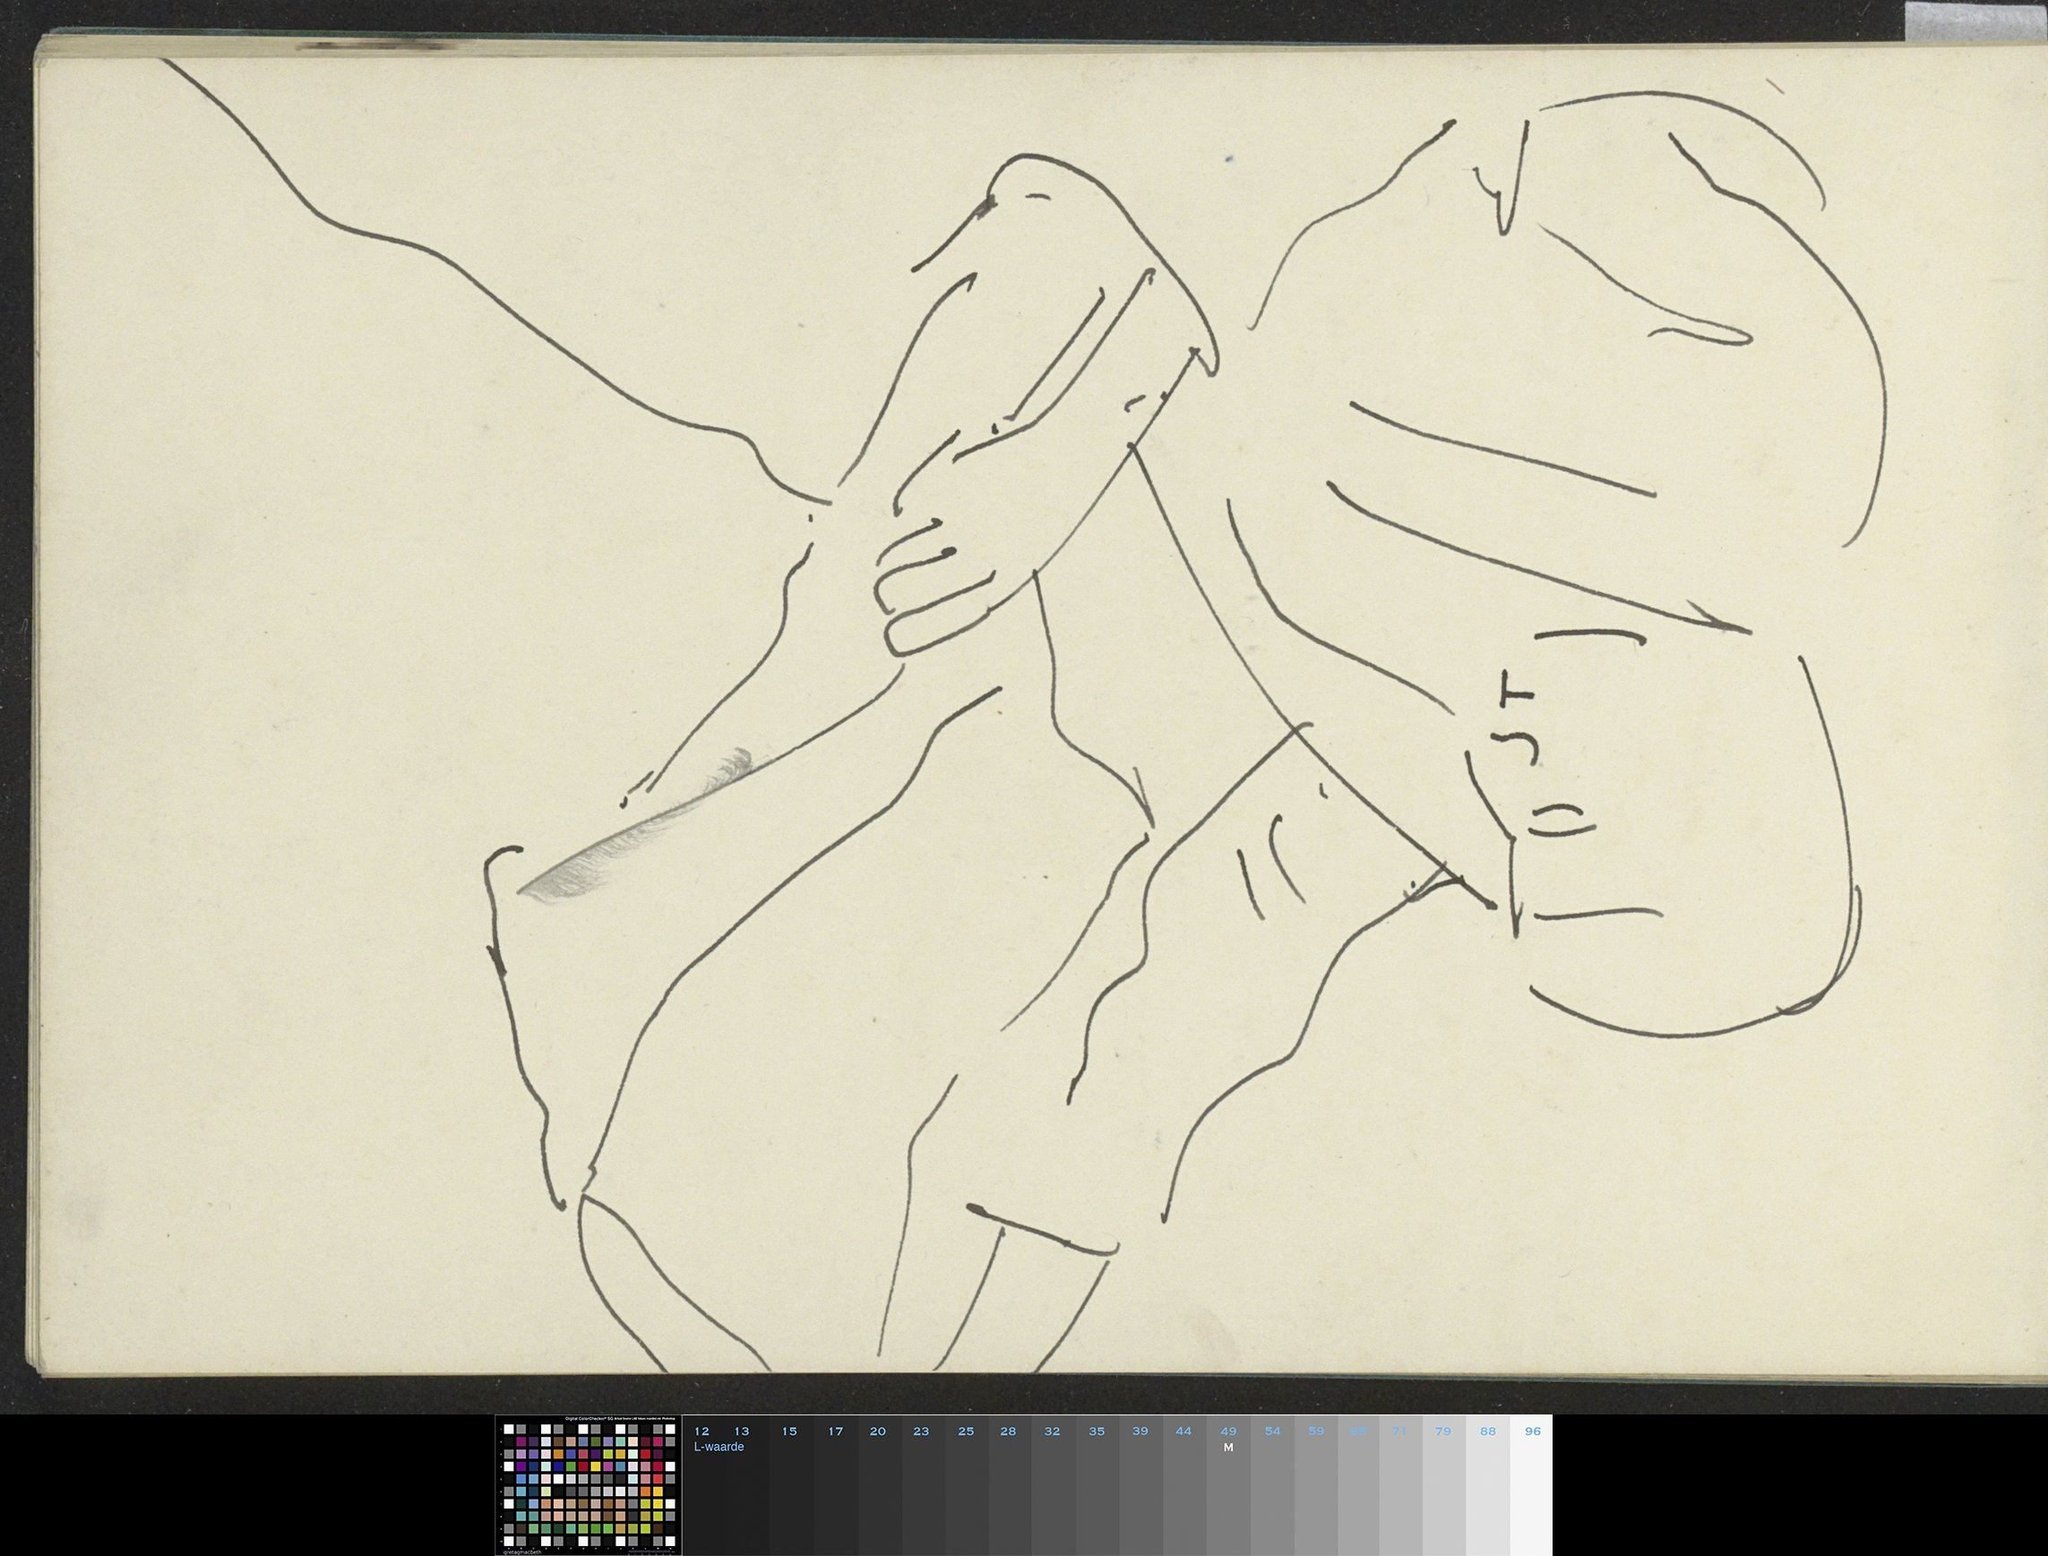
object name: sketchbook leaf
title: Figuur die een krant leest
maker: carel adolph lion cachet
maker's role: draughtsman, print maker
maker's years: 1864-1945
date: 1930-1938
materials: ink, paper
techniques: pen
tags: reading, newspaper, news-sheet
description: Blad 8 verso uit een schetsboek met 9 bladen.